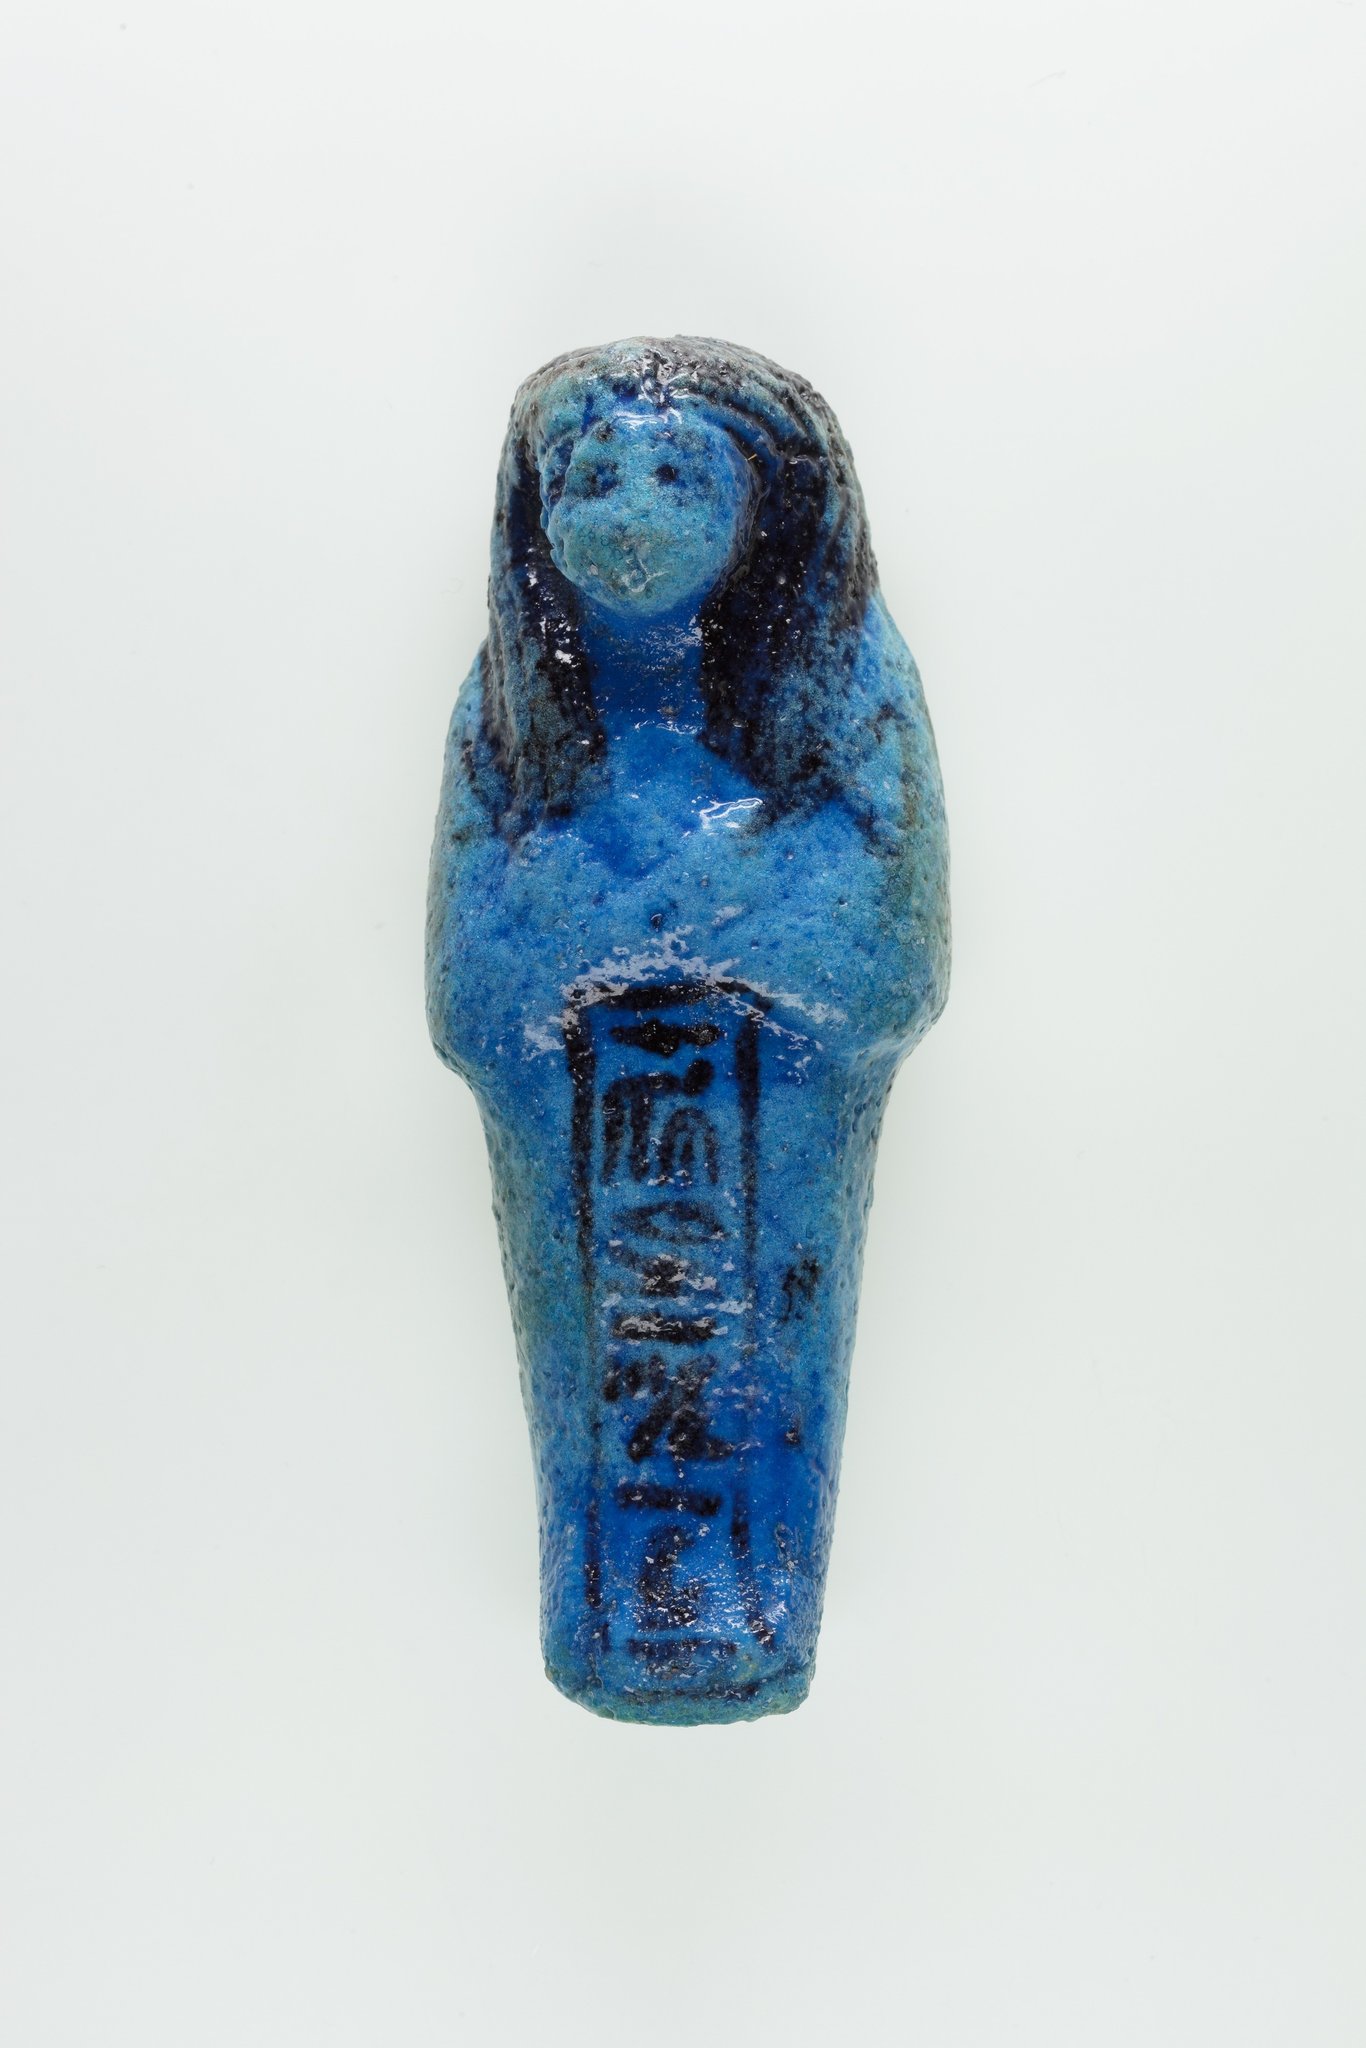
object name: shabti, worker, nauny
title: Worker Shabti of Nauny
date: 1050 BCE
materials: faience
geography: egypt